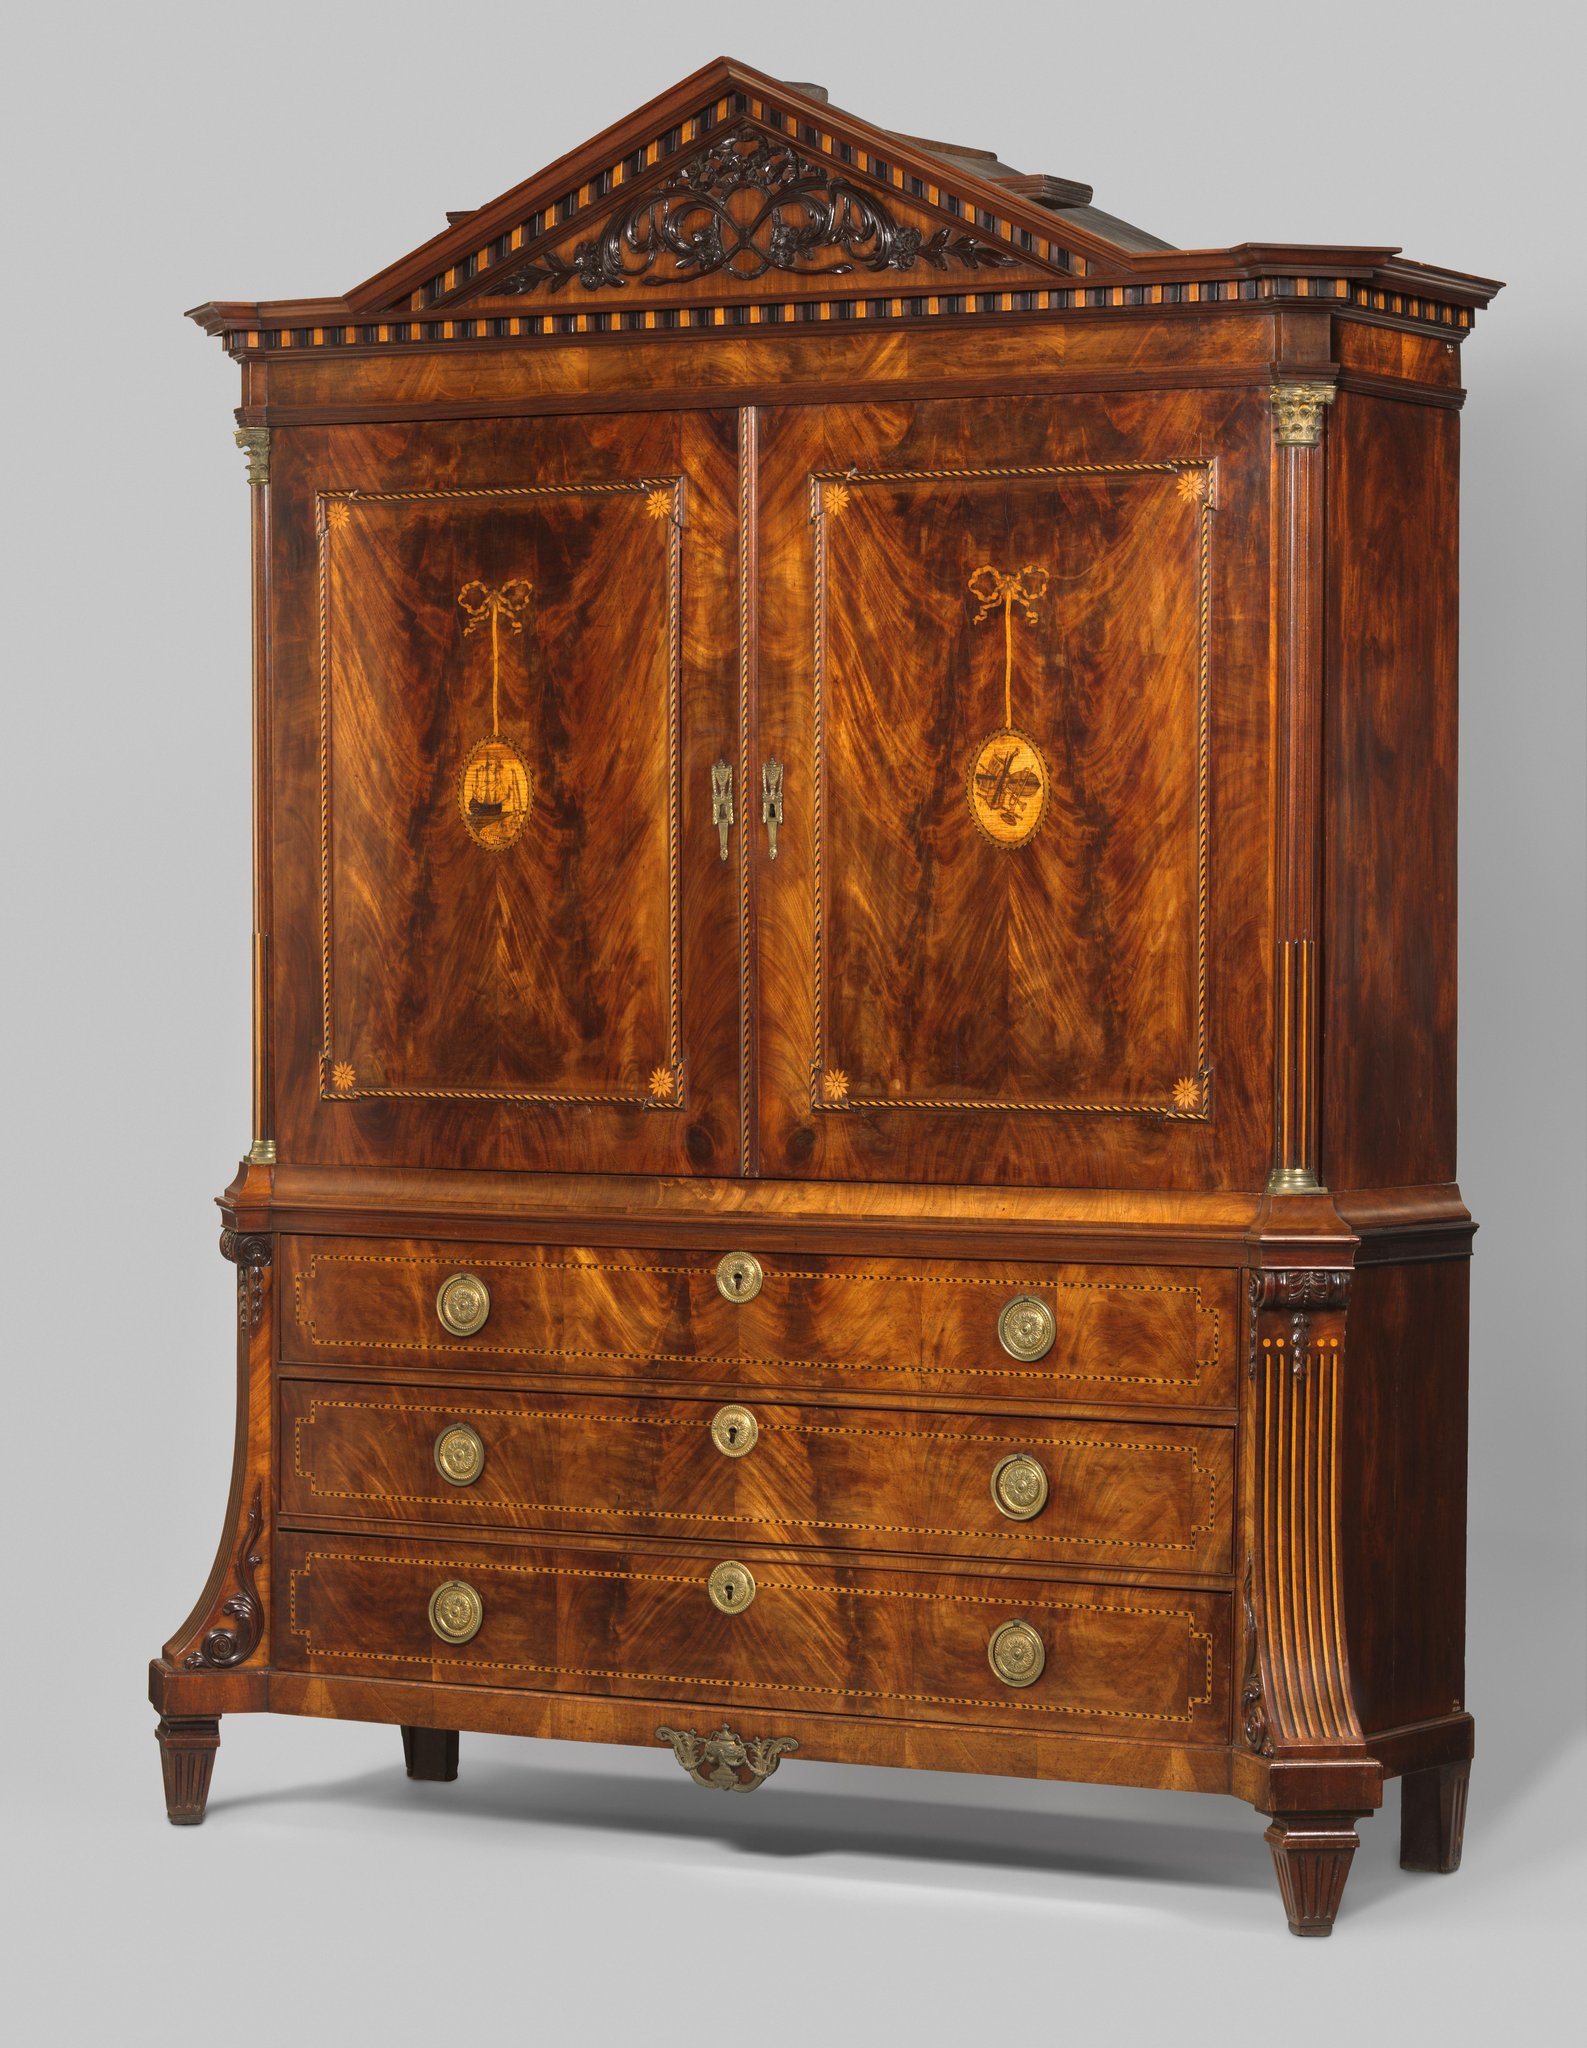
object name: furniture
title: Kabinet, versierd met marqueterie in verschillende houtsoorten. Op de deuren met linten opgehangen medaillons waarin links een zeilschip en rechts muziekinstrumenten.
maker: Anonymous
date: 1775-1800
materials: copper, wood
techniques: marquetry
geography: northern netherlands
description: Cabinet. Oak, veneered with mahogany and other woods. Netherlands, c. 1780 - 1800. Miss E.W. Engels bequest, 1941.